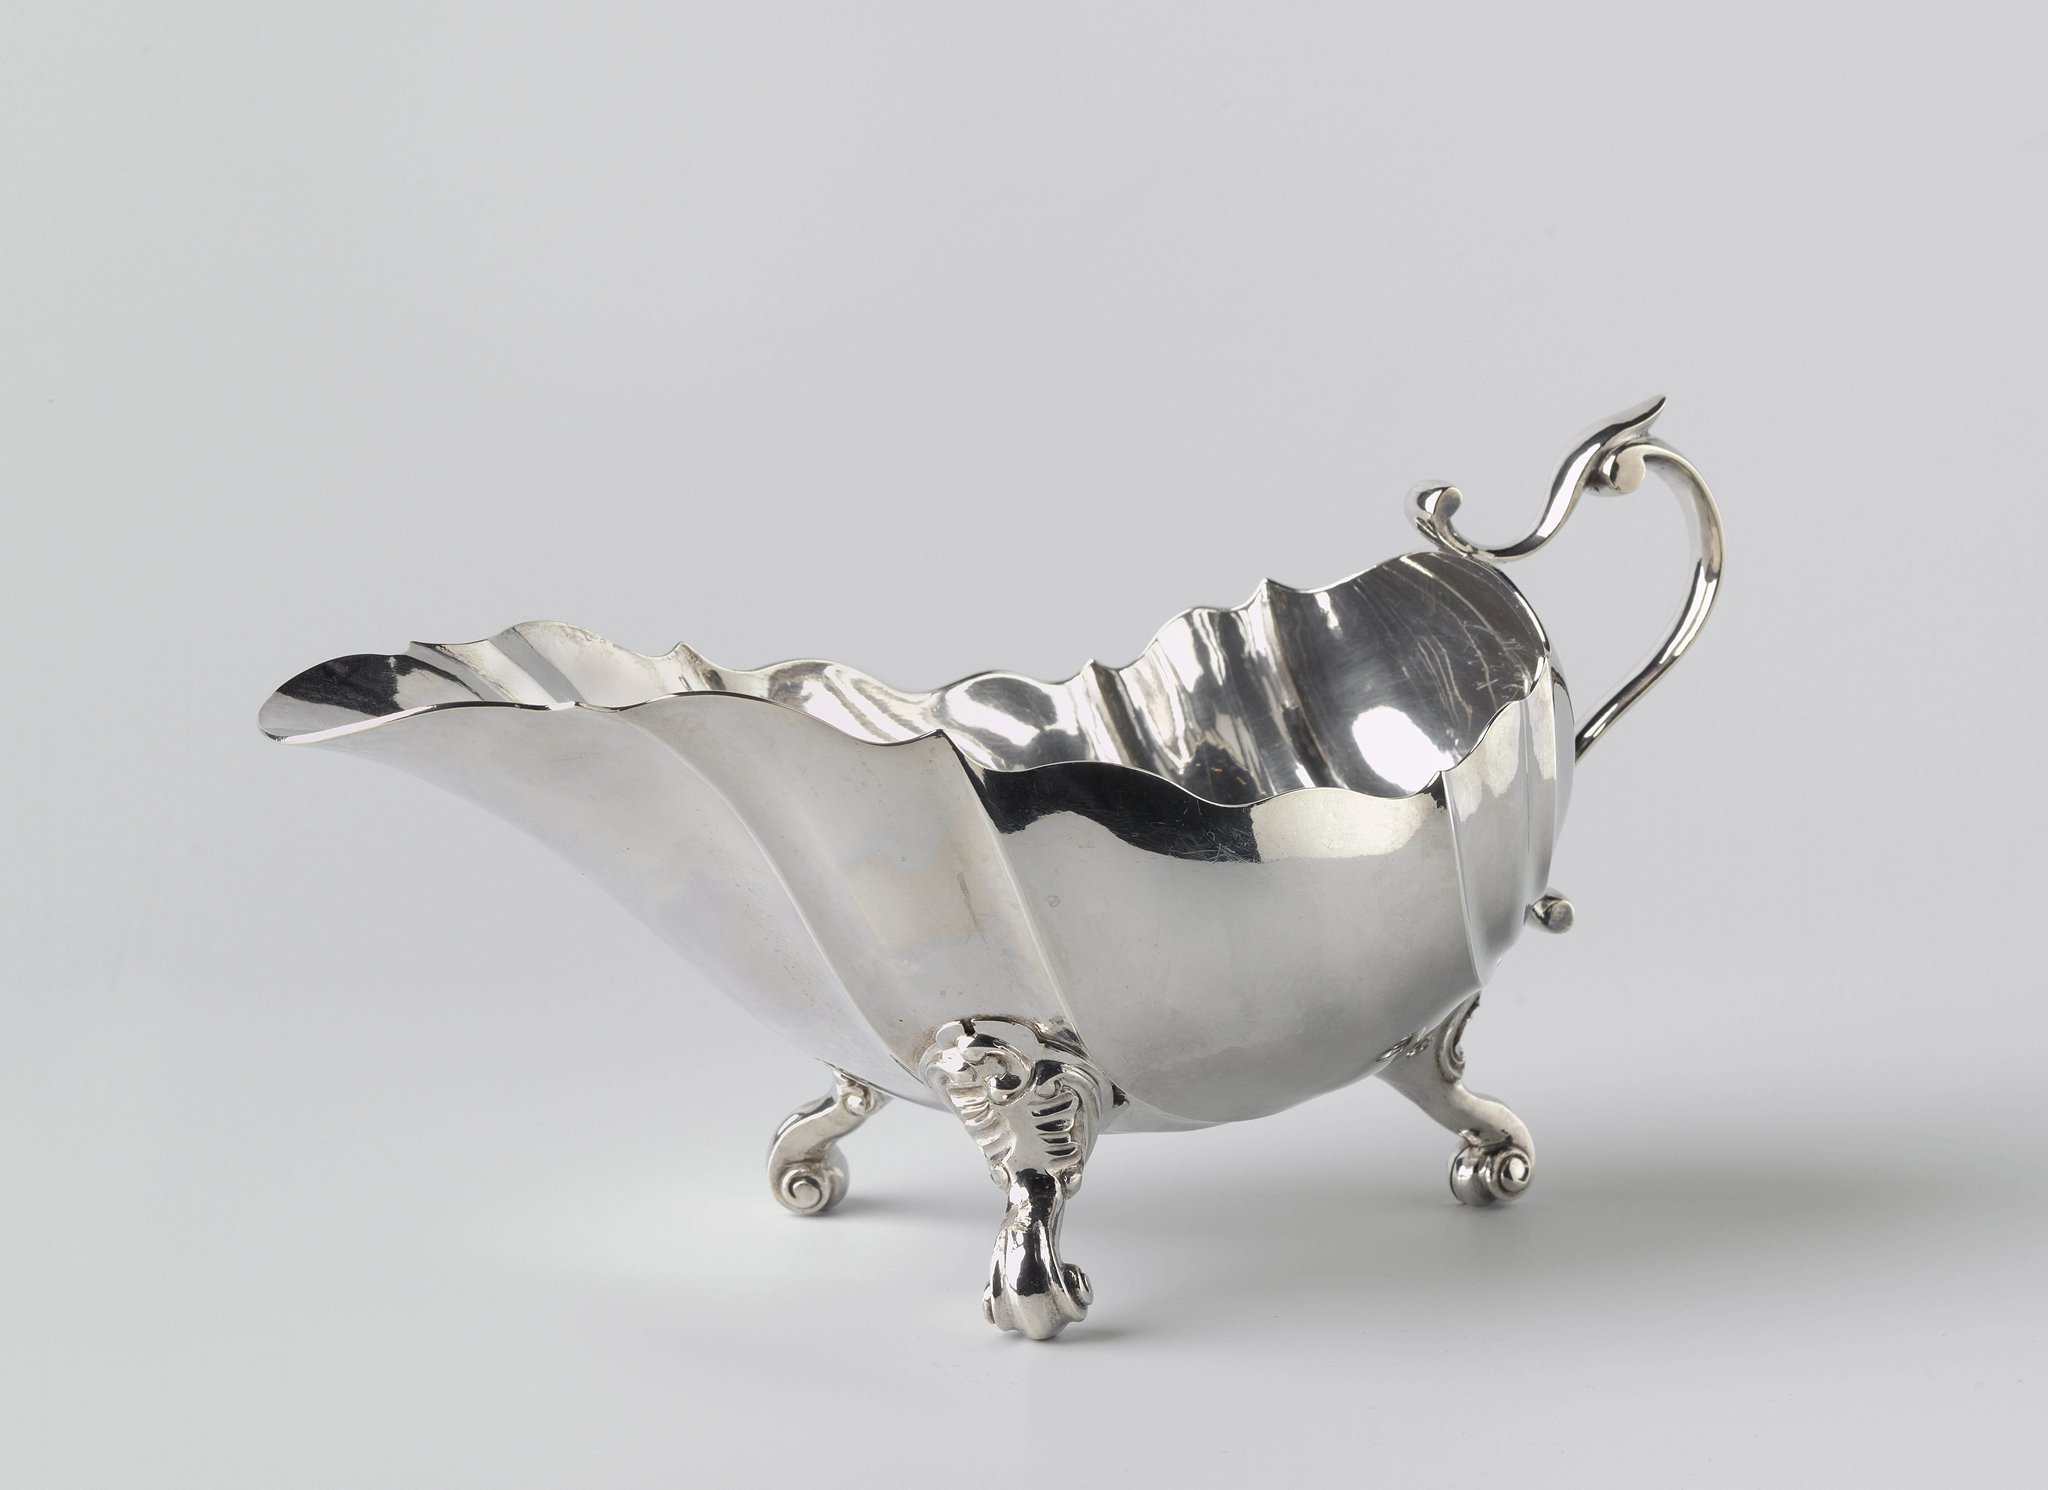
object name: sauceboat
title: Sauskom van zilver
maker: valentijn caspar bömcke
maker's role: silversmith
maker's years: 1726-1782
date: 1764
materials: silver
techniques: casting, hammering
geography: amsterdam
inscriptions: date letter: ‘E’, maker's mark, town mark, duty mark, alloy mark, redemption mark: ‘L’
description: Schelpvormige sauskom met één oor op drie poten. Elke poot is opgebouwd uit voluten, en op de schouder versierd met een rocaille. Het oor bestaat uit voluten. De sauskom is gemerkt.